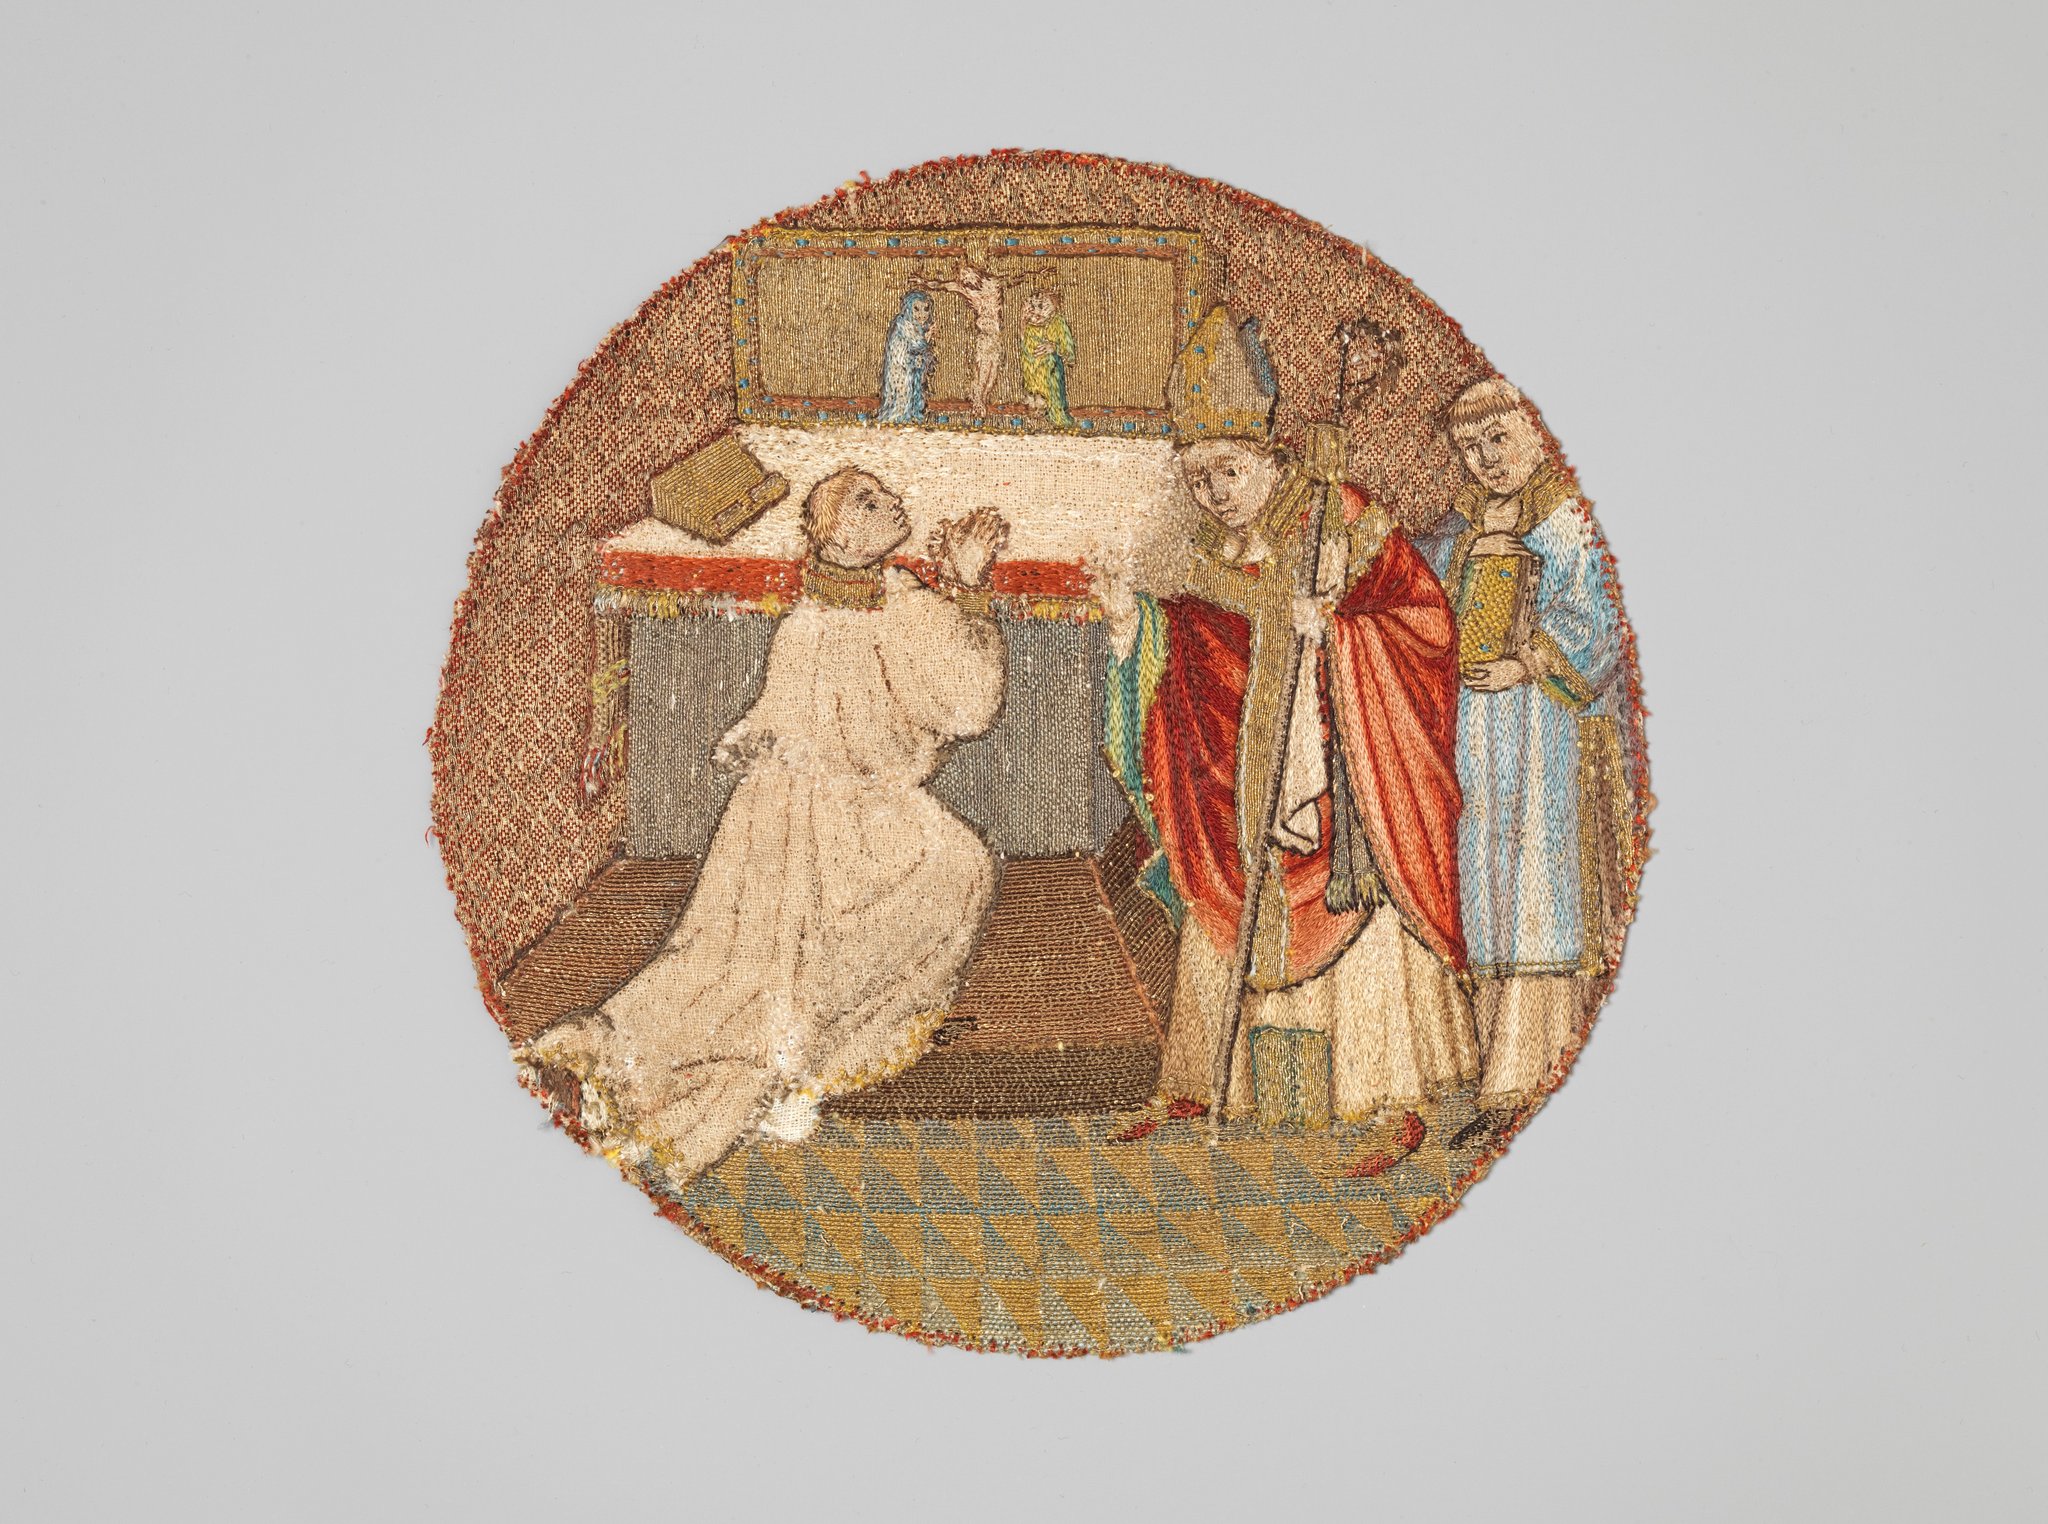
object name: roundel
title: Saint Martin and Saint Hilary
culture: flemish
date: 1430-1435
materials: gilt, linen, metal, textile, silk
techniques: embroidery, laid work, weave, stitching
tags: men,saints